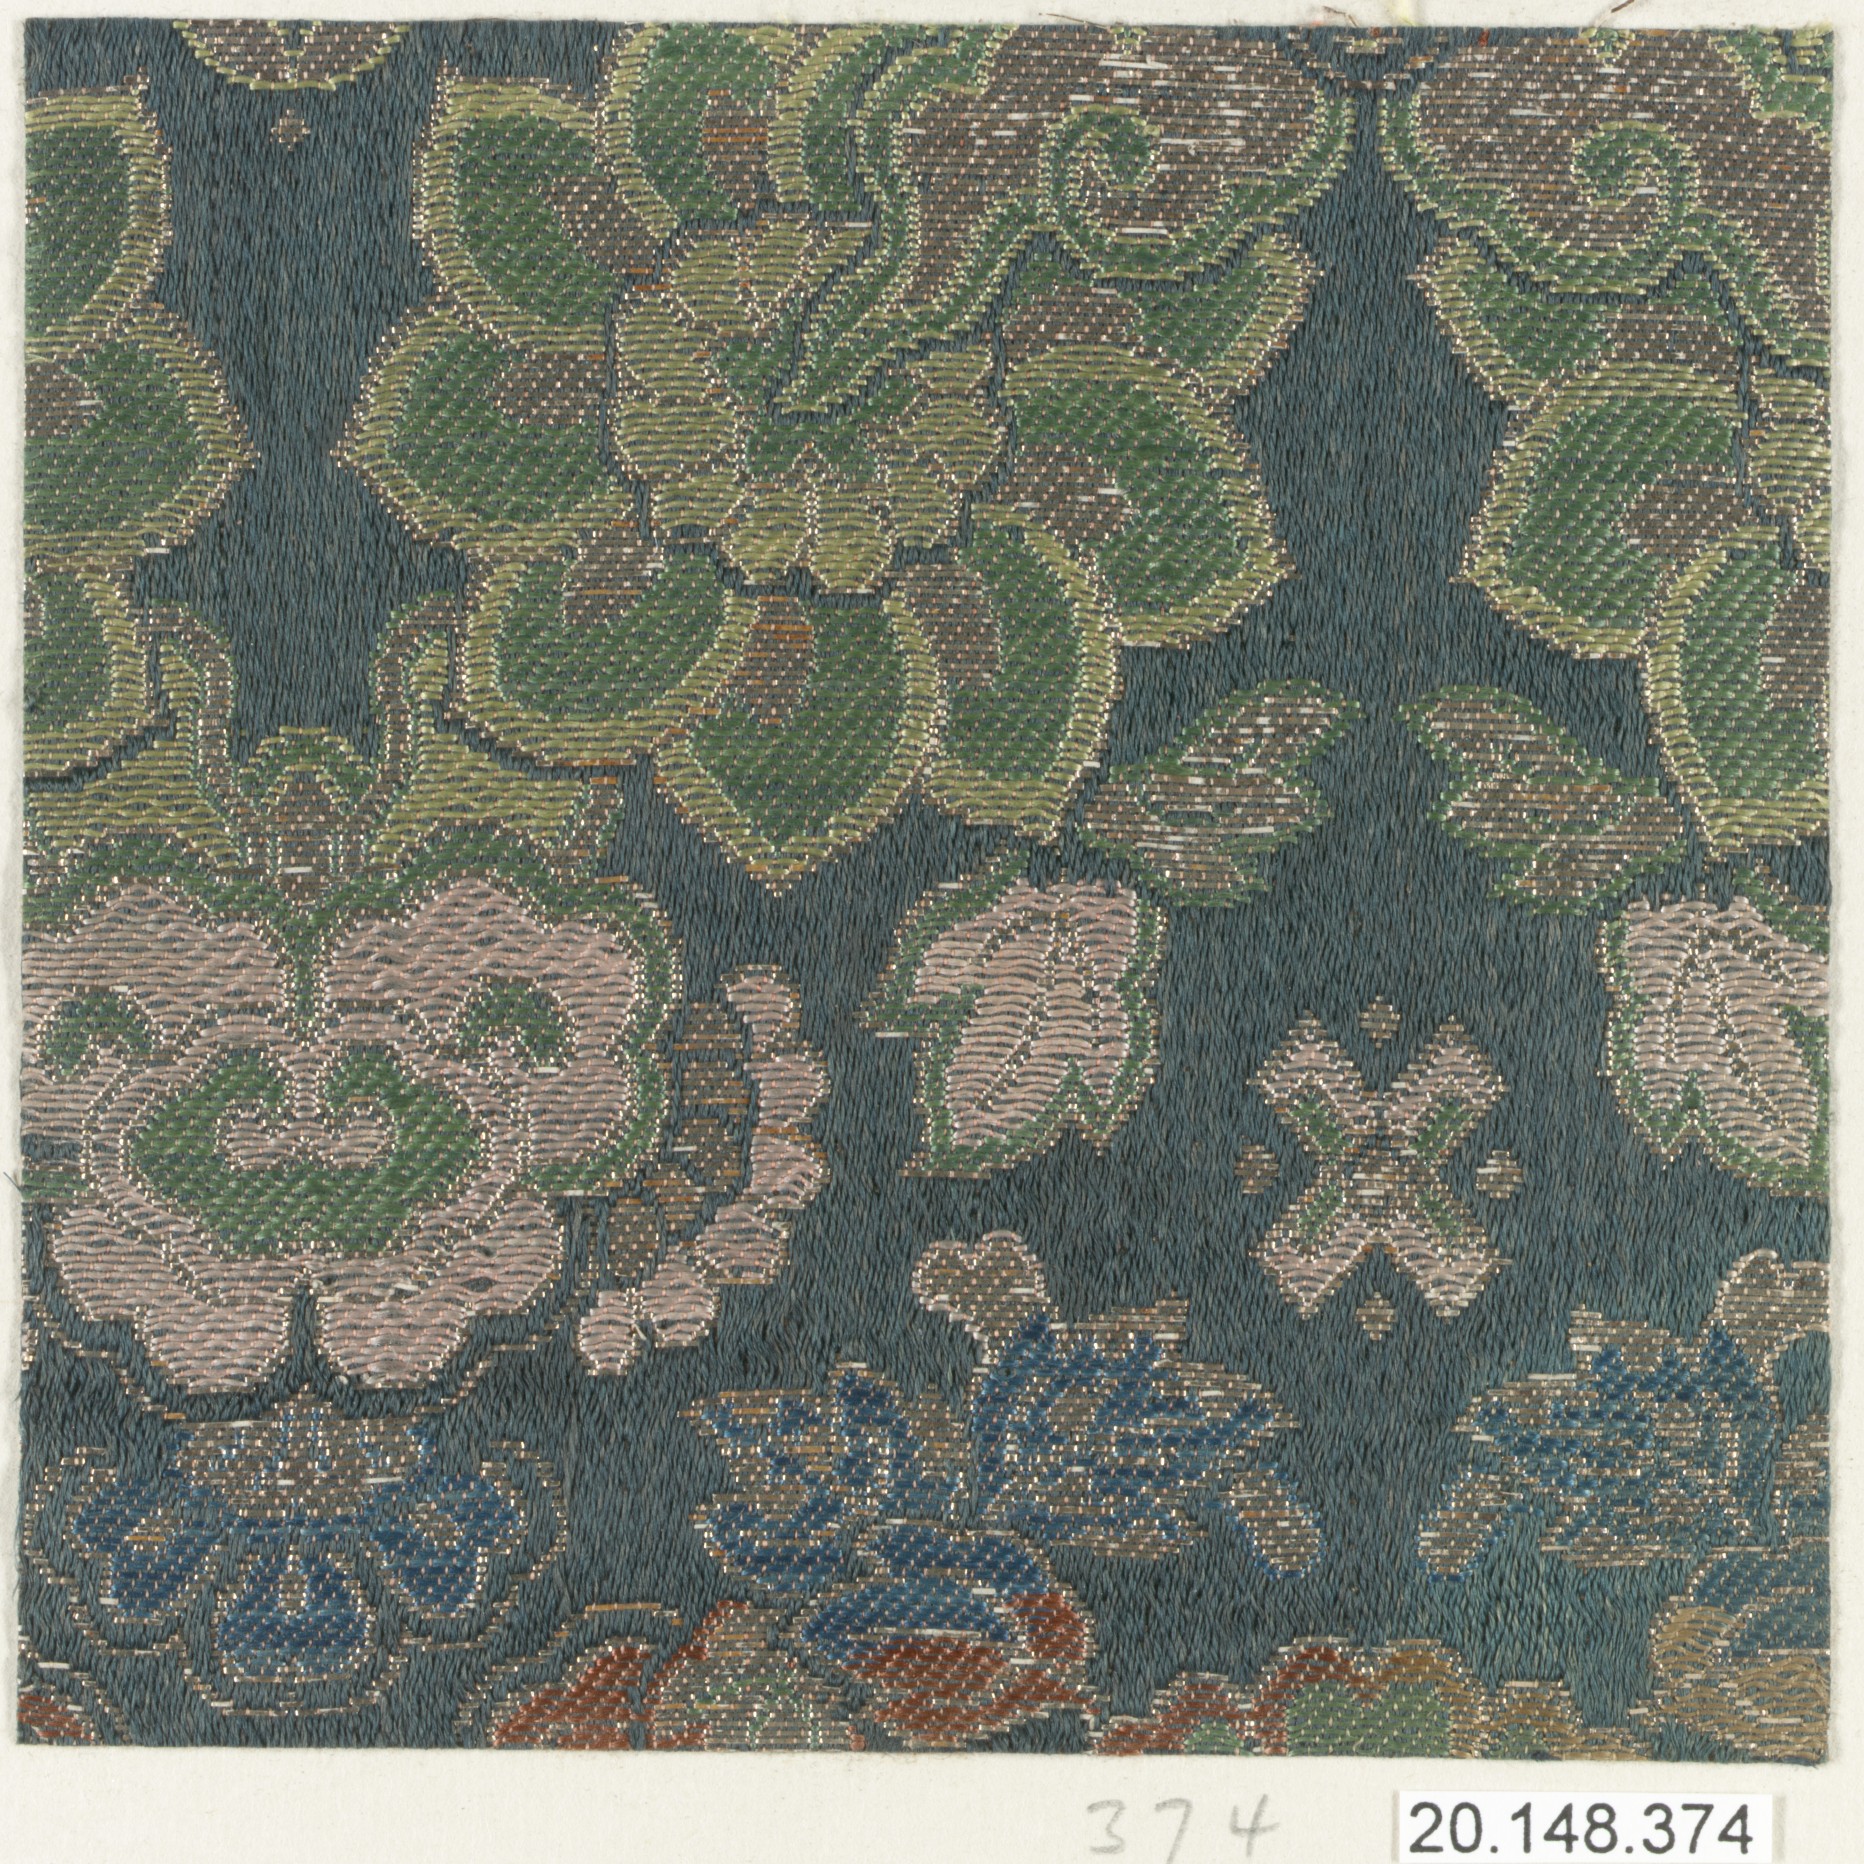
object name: piece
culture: japanese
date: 1701-1800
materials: silk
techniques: compound weave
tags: flowers